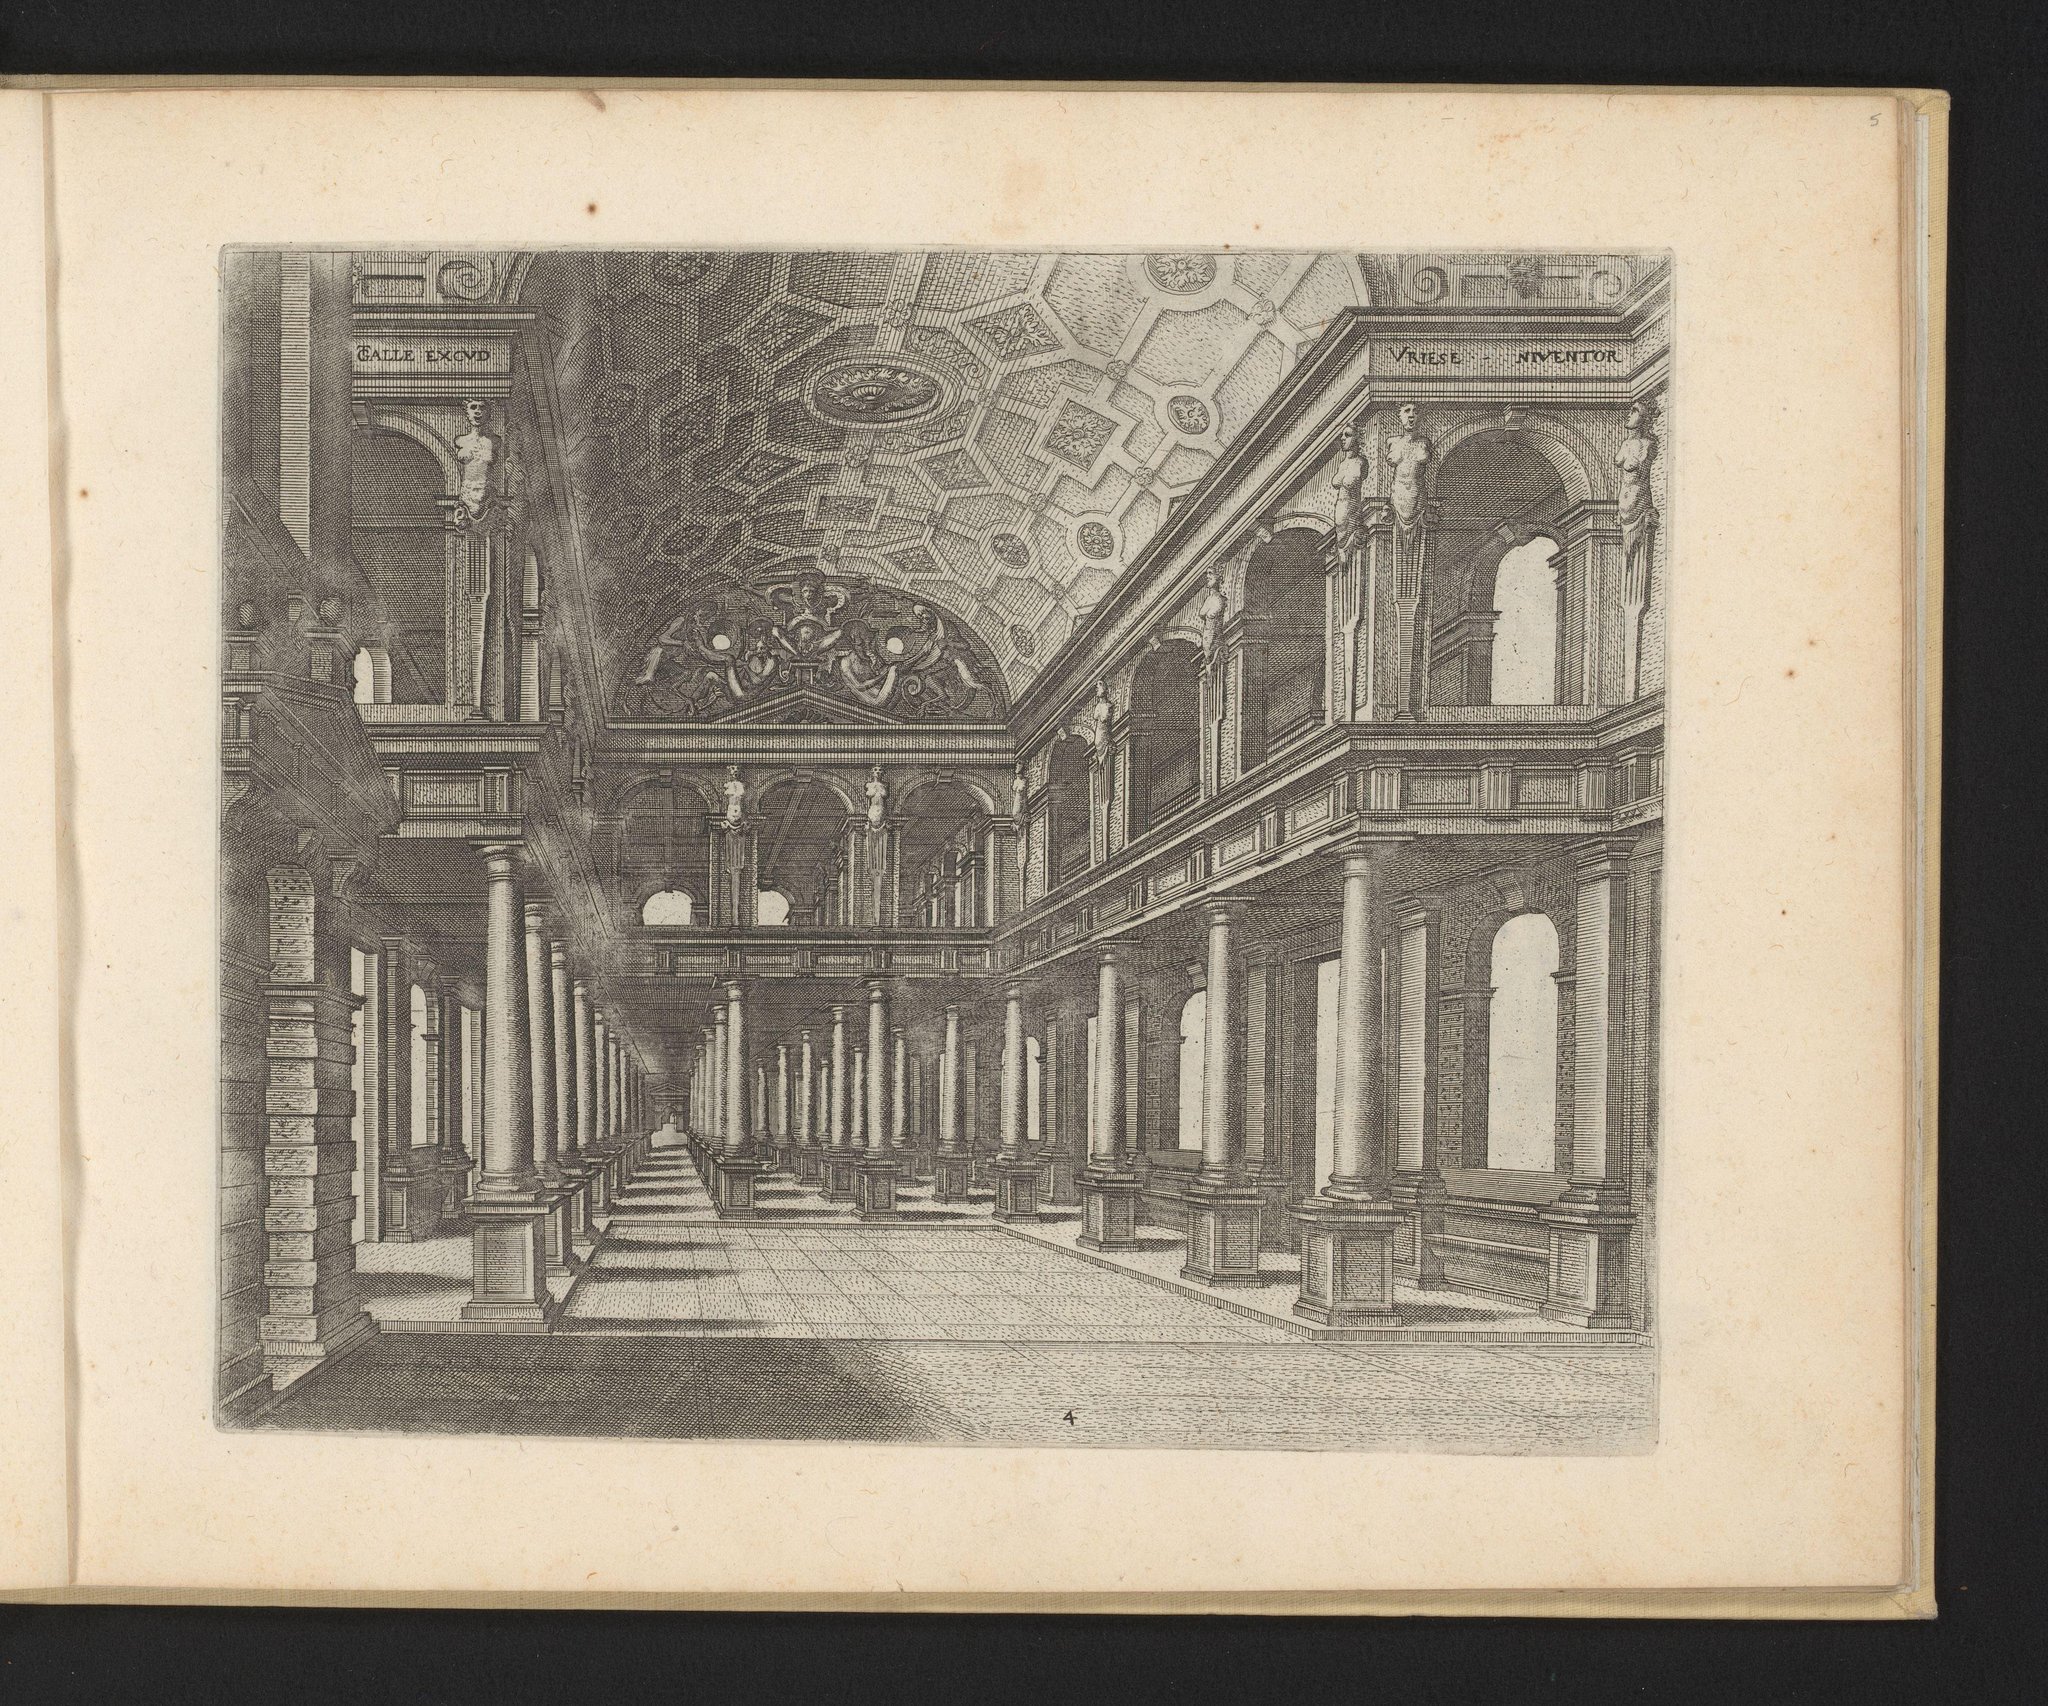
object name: album leaf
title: Gezicht in een hal met zuilengalerijen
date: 1601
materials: paper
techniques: engraving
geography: antwerp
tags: colonnade, interior of the house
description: Gezicht in een hal met zuilen van de Toscaanse orde. De prent maakt deel uit van een album.